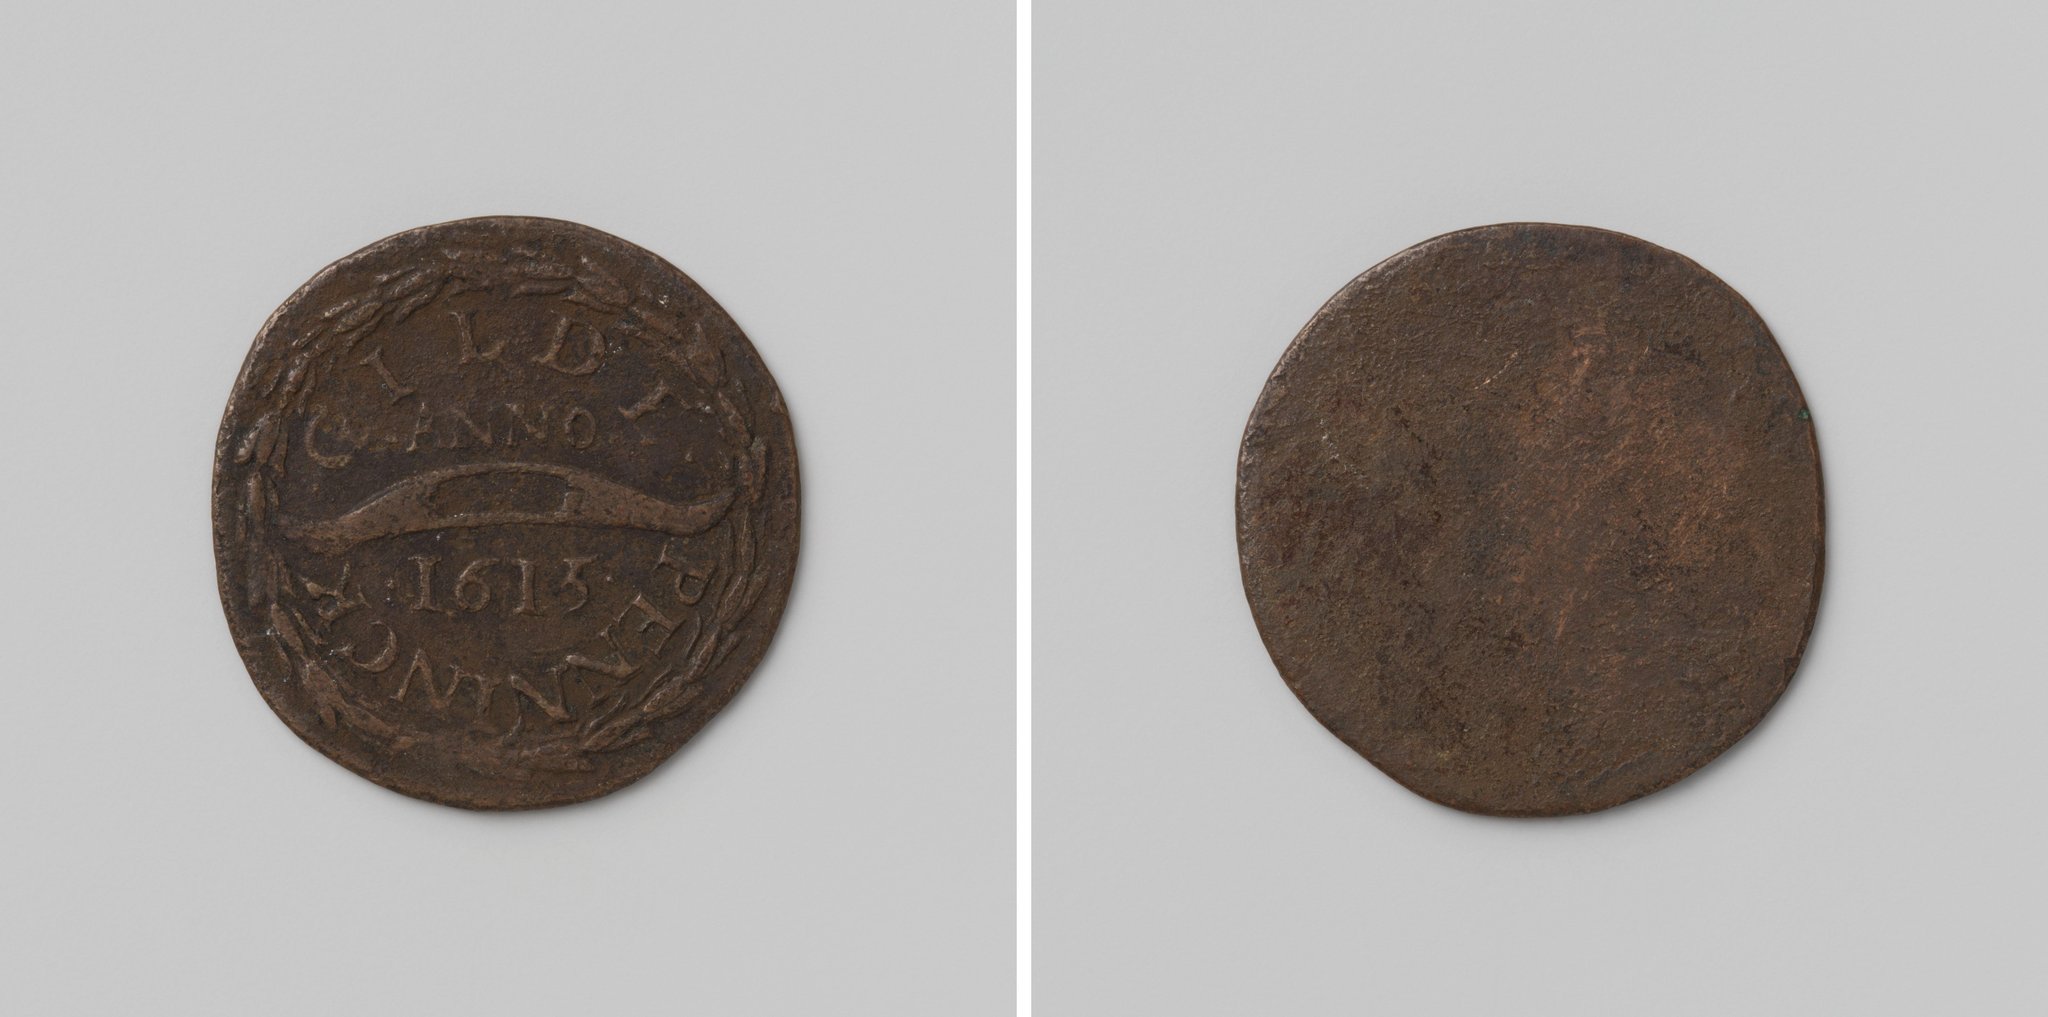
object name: medal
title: Linnenweversgilde van Amsterdam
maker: Anonymous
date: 1615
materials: copper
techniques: striking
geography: amsterdam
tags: amsterdam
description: Eenzijdige koperen penning. Voorzijde: weversspoel boven jaartal binnen omschrift en bladerkrans. Keerzijde: blanco